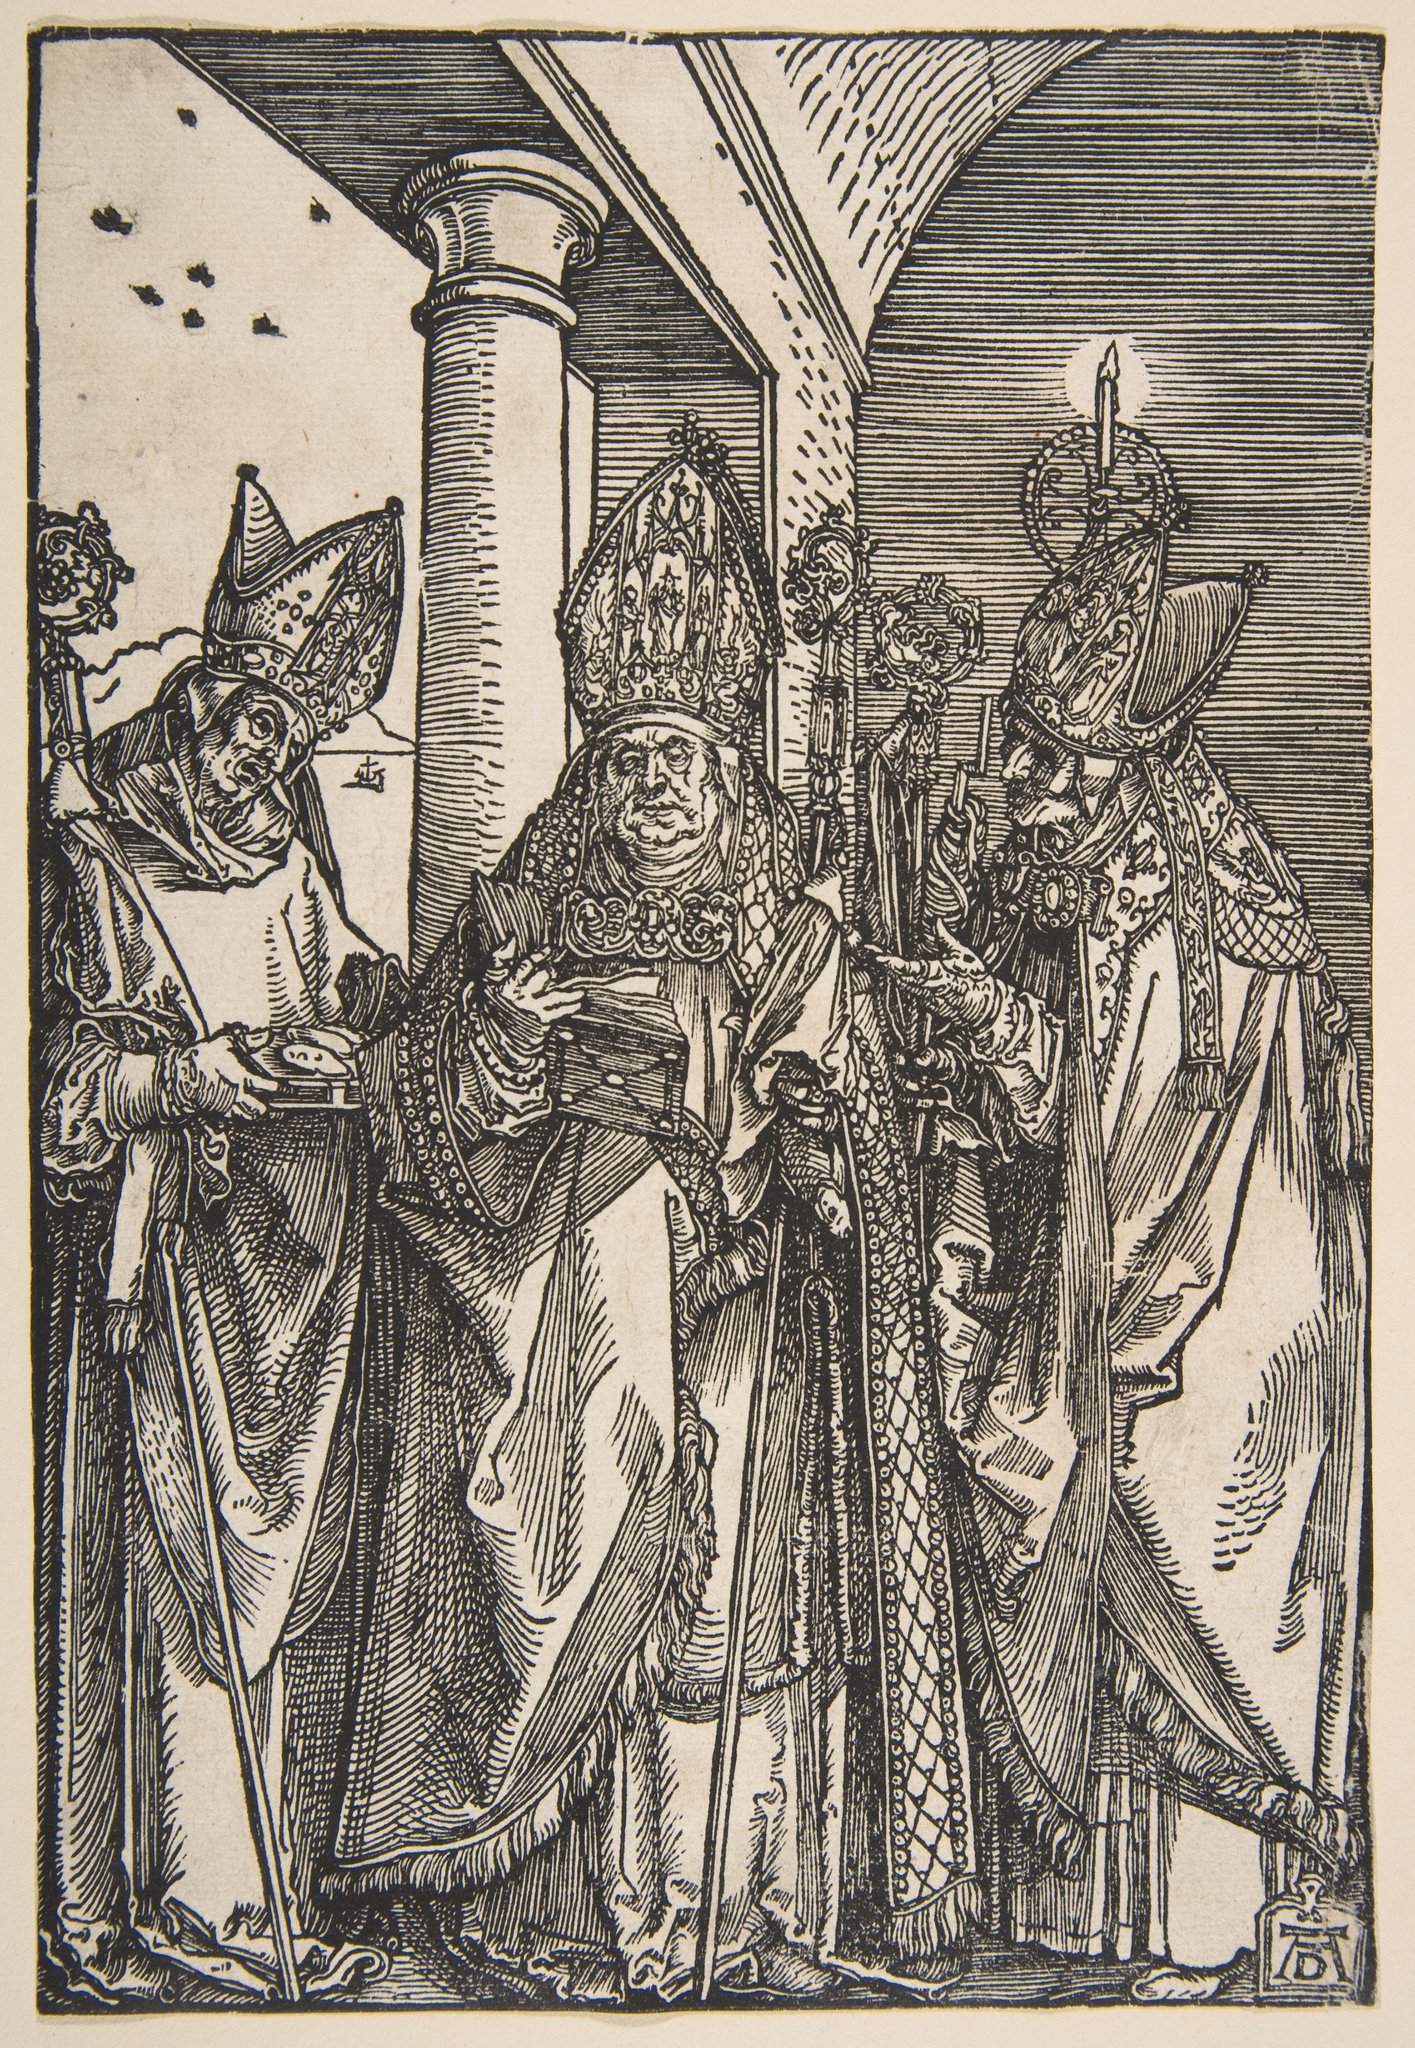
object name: print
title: Saints Nicholas, Ulrich and Erasmus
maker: albrecht dürer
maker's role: artist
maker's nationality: german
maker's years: 1471-1528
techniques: woodcut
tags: men,saints